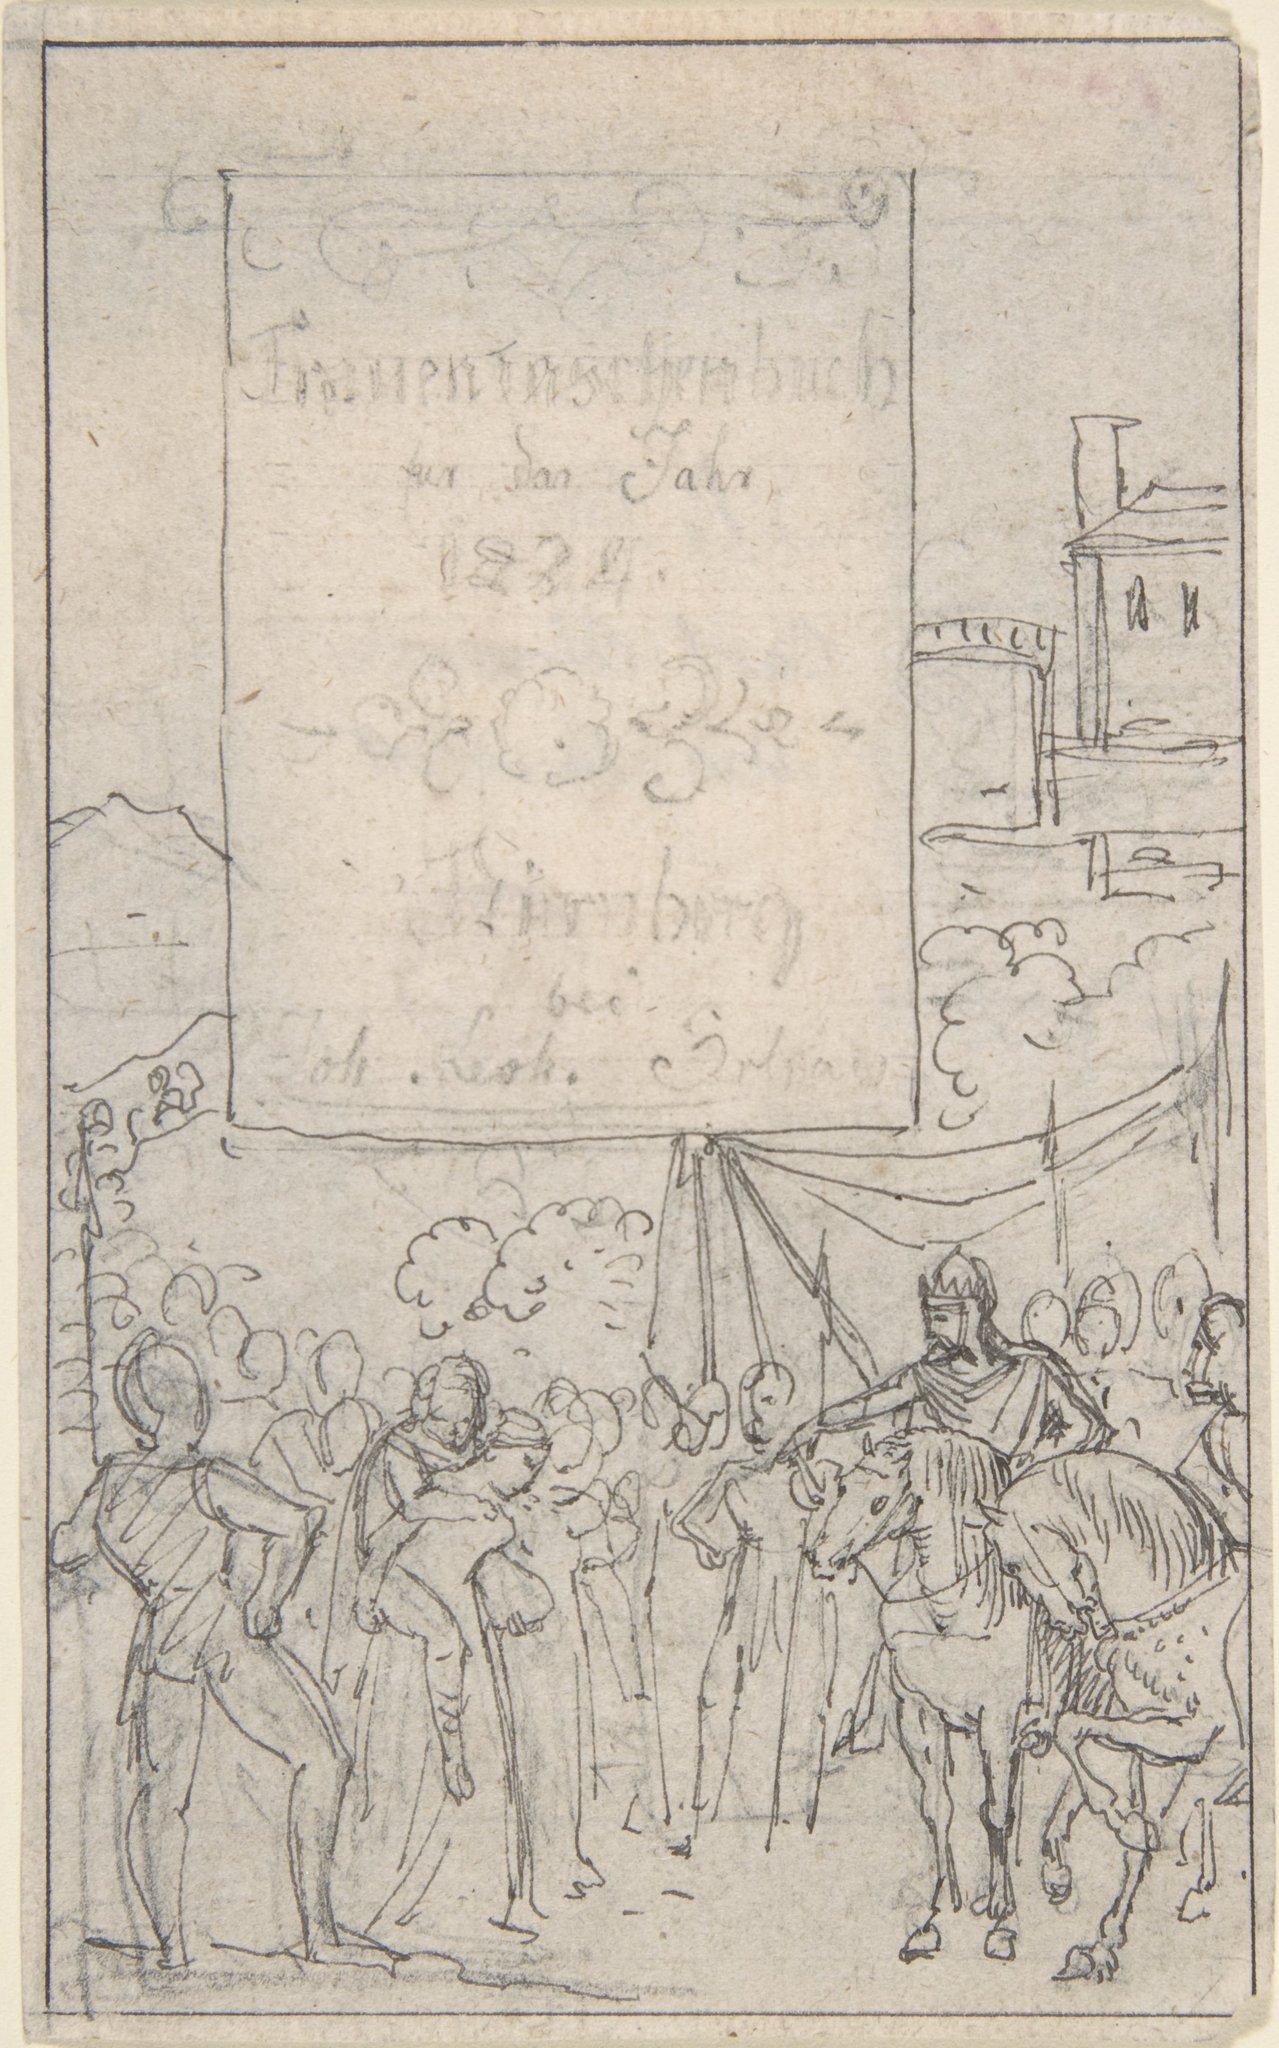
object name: drawing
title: Study for a Title Page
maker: carl alexander von heideloff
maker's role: artist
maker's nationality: german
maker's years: 1789-1865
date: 1809-1865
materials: chalk, ink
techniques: incising, pen, transfer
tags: men,women,horses,crowd